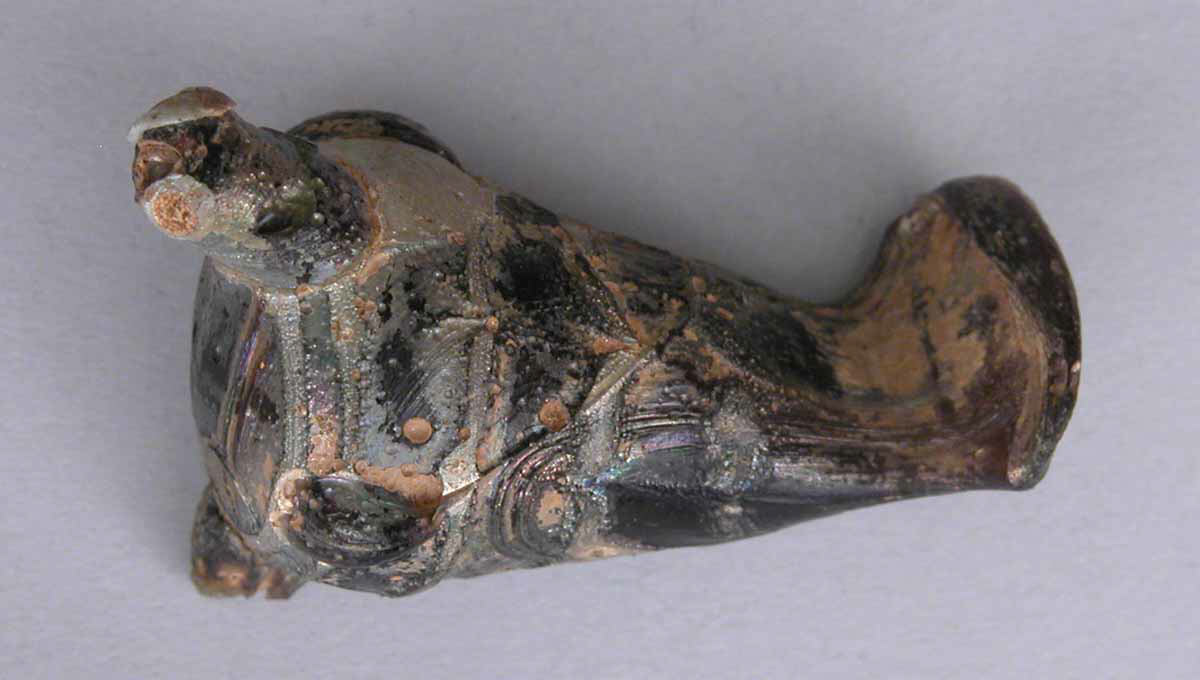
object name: figure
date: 701-900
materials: glass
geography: egypt